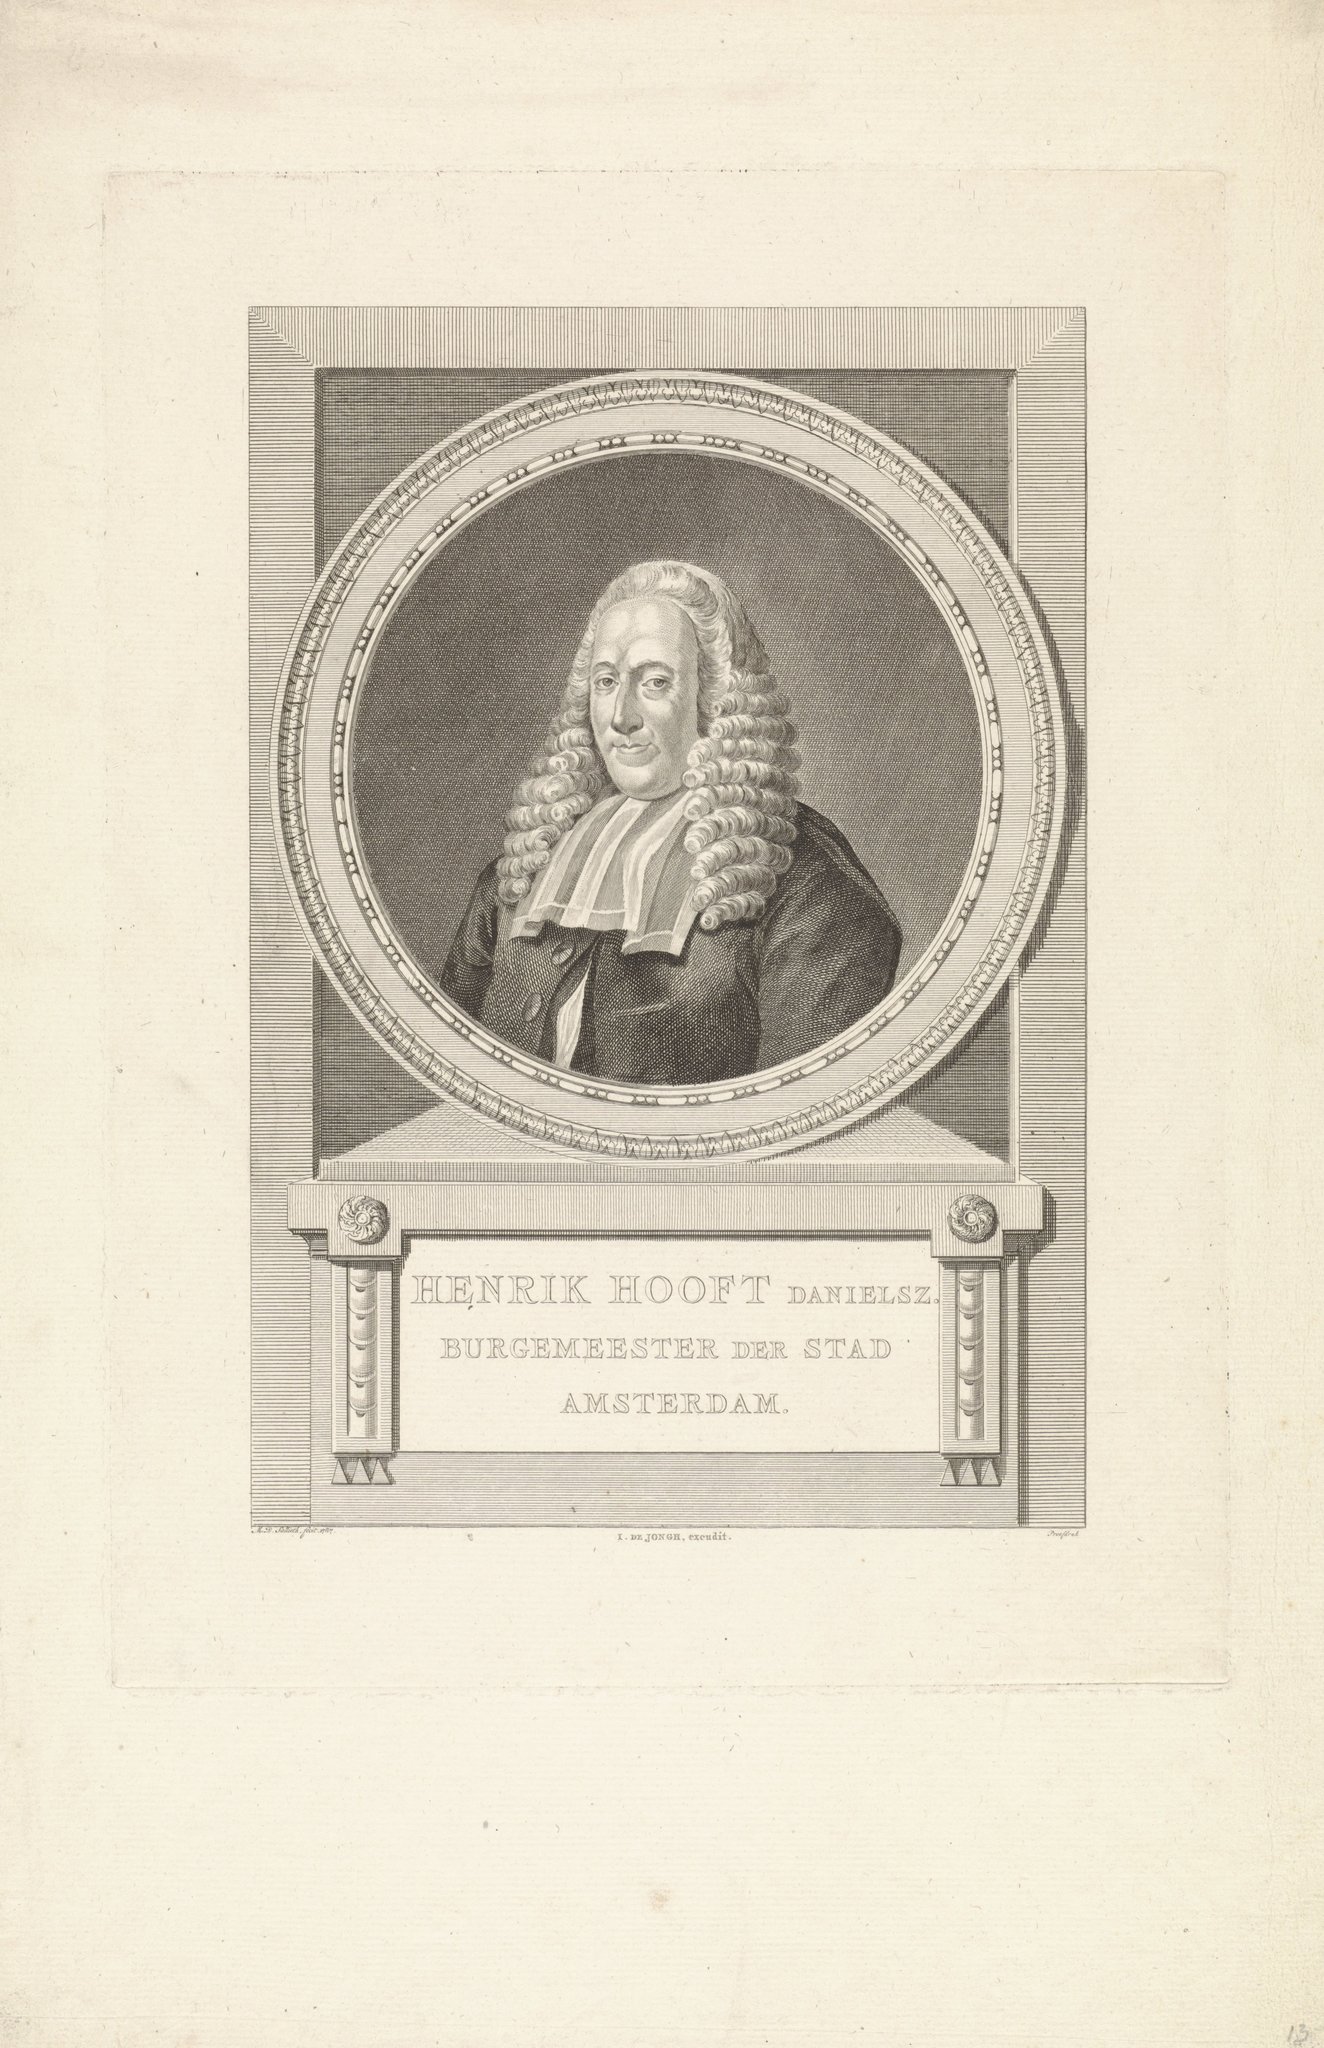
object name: print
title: Portret van de Amsterdamse burgemeester Hendrik Danielsz Hooft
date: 1787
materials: paper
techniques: engraving, etching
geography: amsterdam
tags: amsterdam, mayor, hendrik danielsz. hooft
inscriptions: collector's mark: Lugt 2228